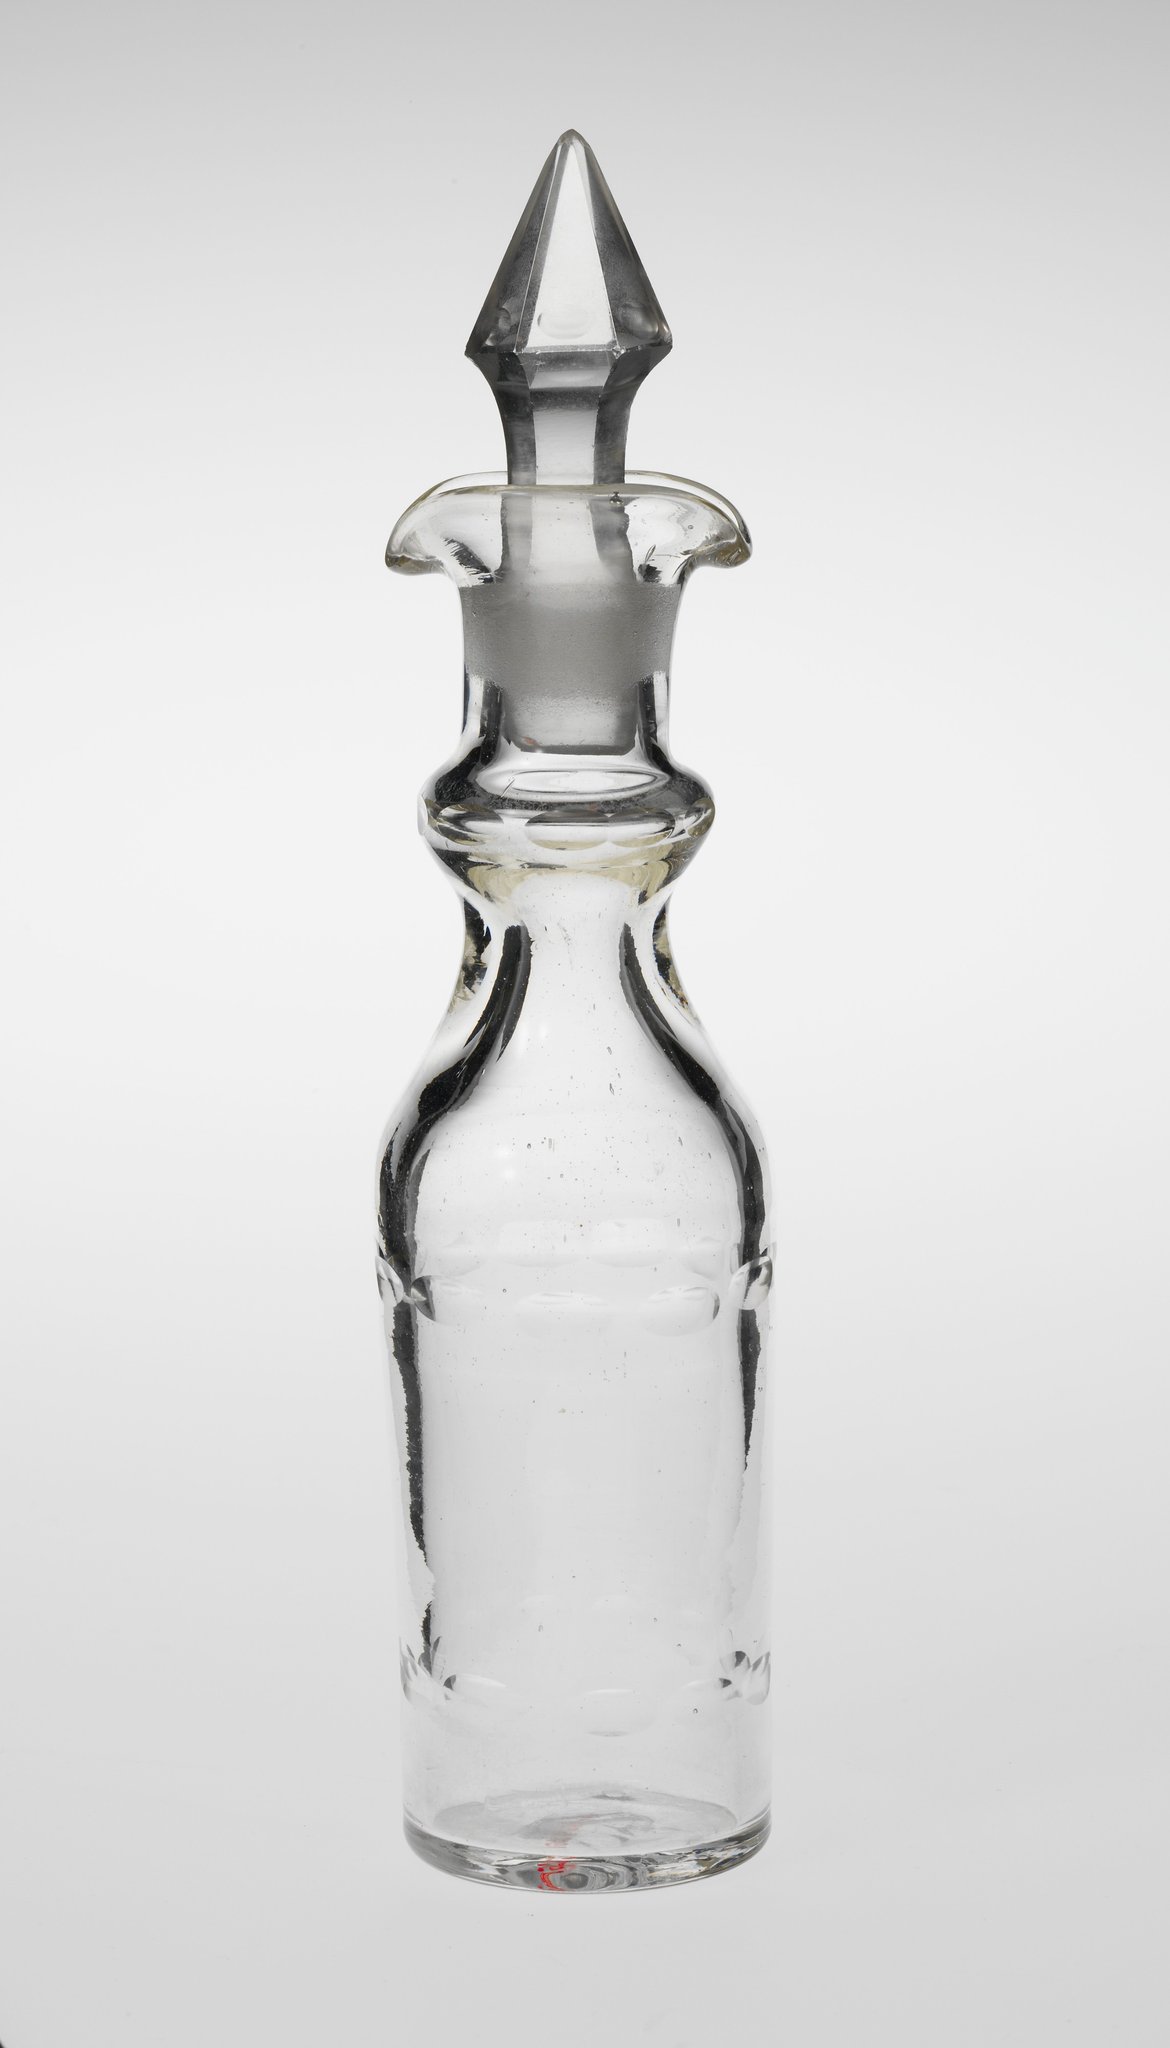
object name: bottle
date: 1700-1800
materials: glass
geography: ireland